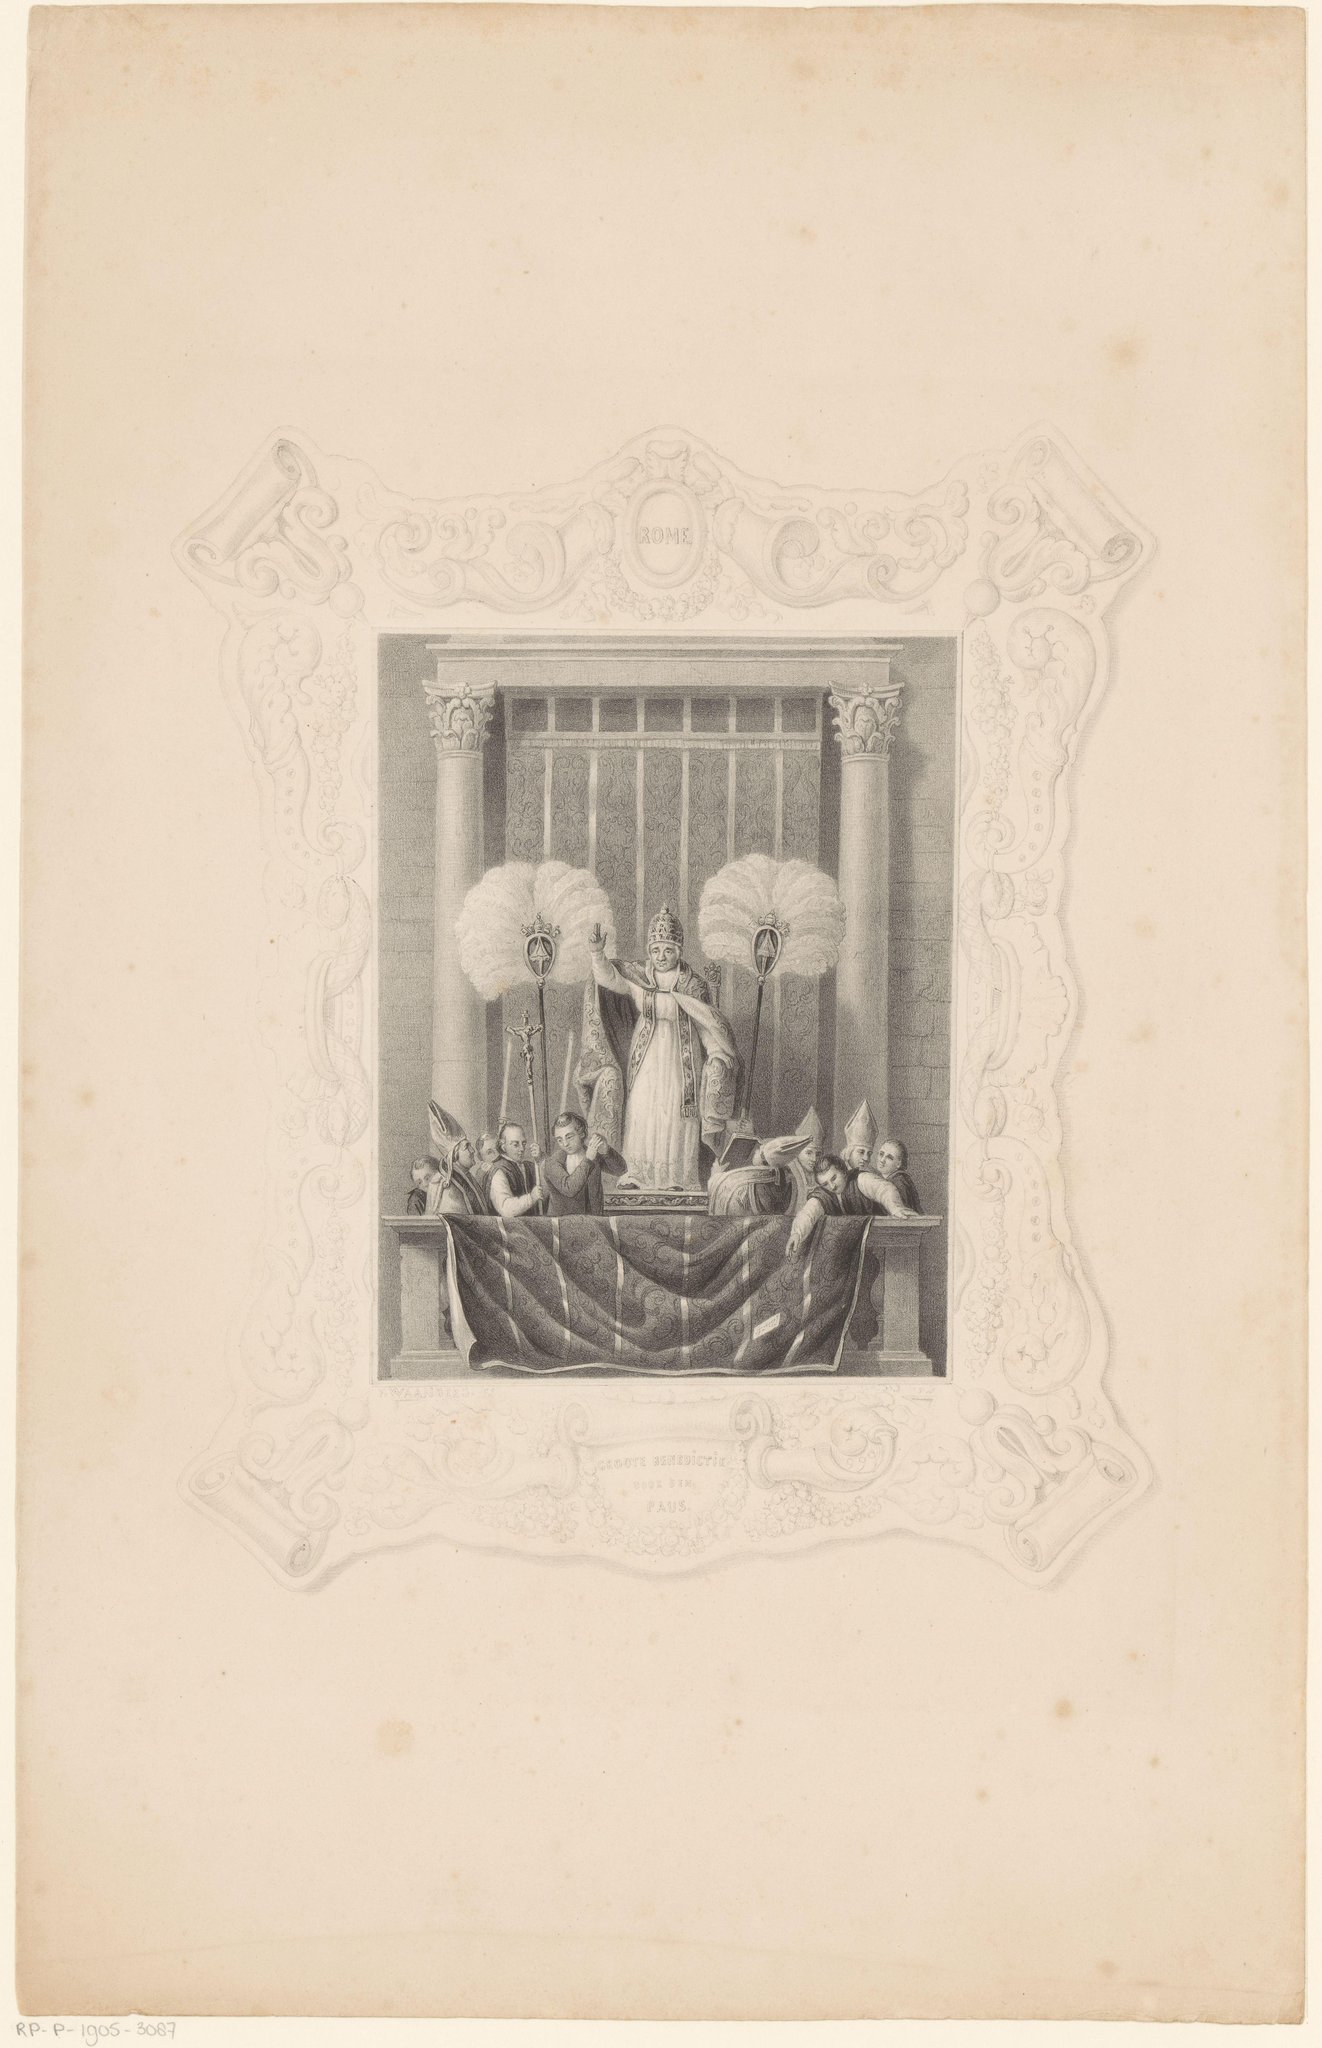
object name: print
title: Rome / Groote benedictie door den Paus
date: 1838-1839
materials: paper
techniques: lithograph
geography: breda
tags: pope's blessing at easterday ('urbi et orbi'), pope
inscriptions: collector's mark: Lugt 2228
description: De paus staat op het balkon van de Sint-Pietersbasiliek met een zegenend gebaar. De voorstelling is gevat in een ornamentele omlijsting.